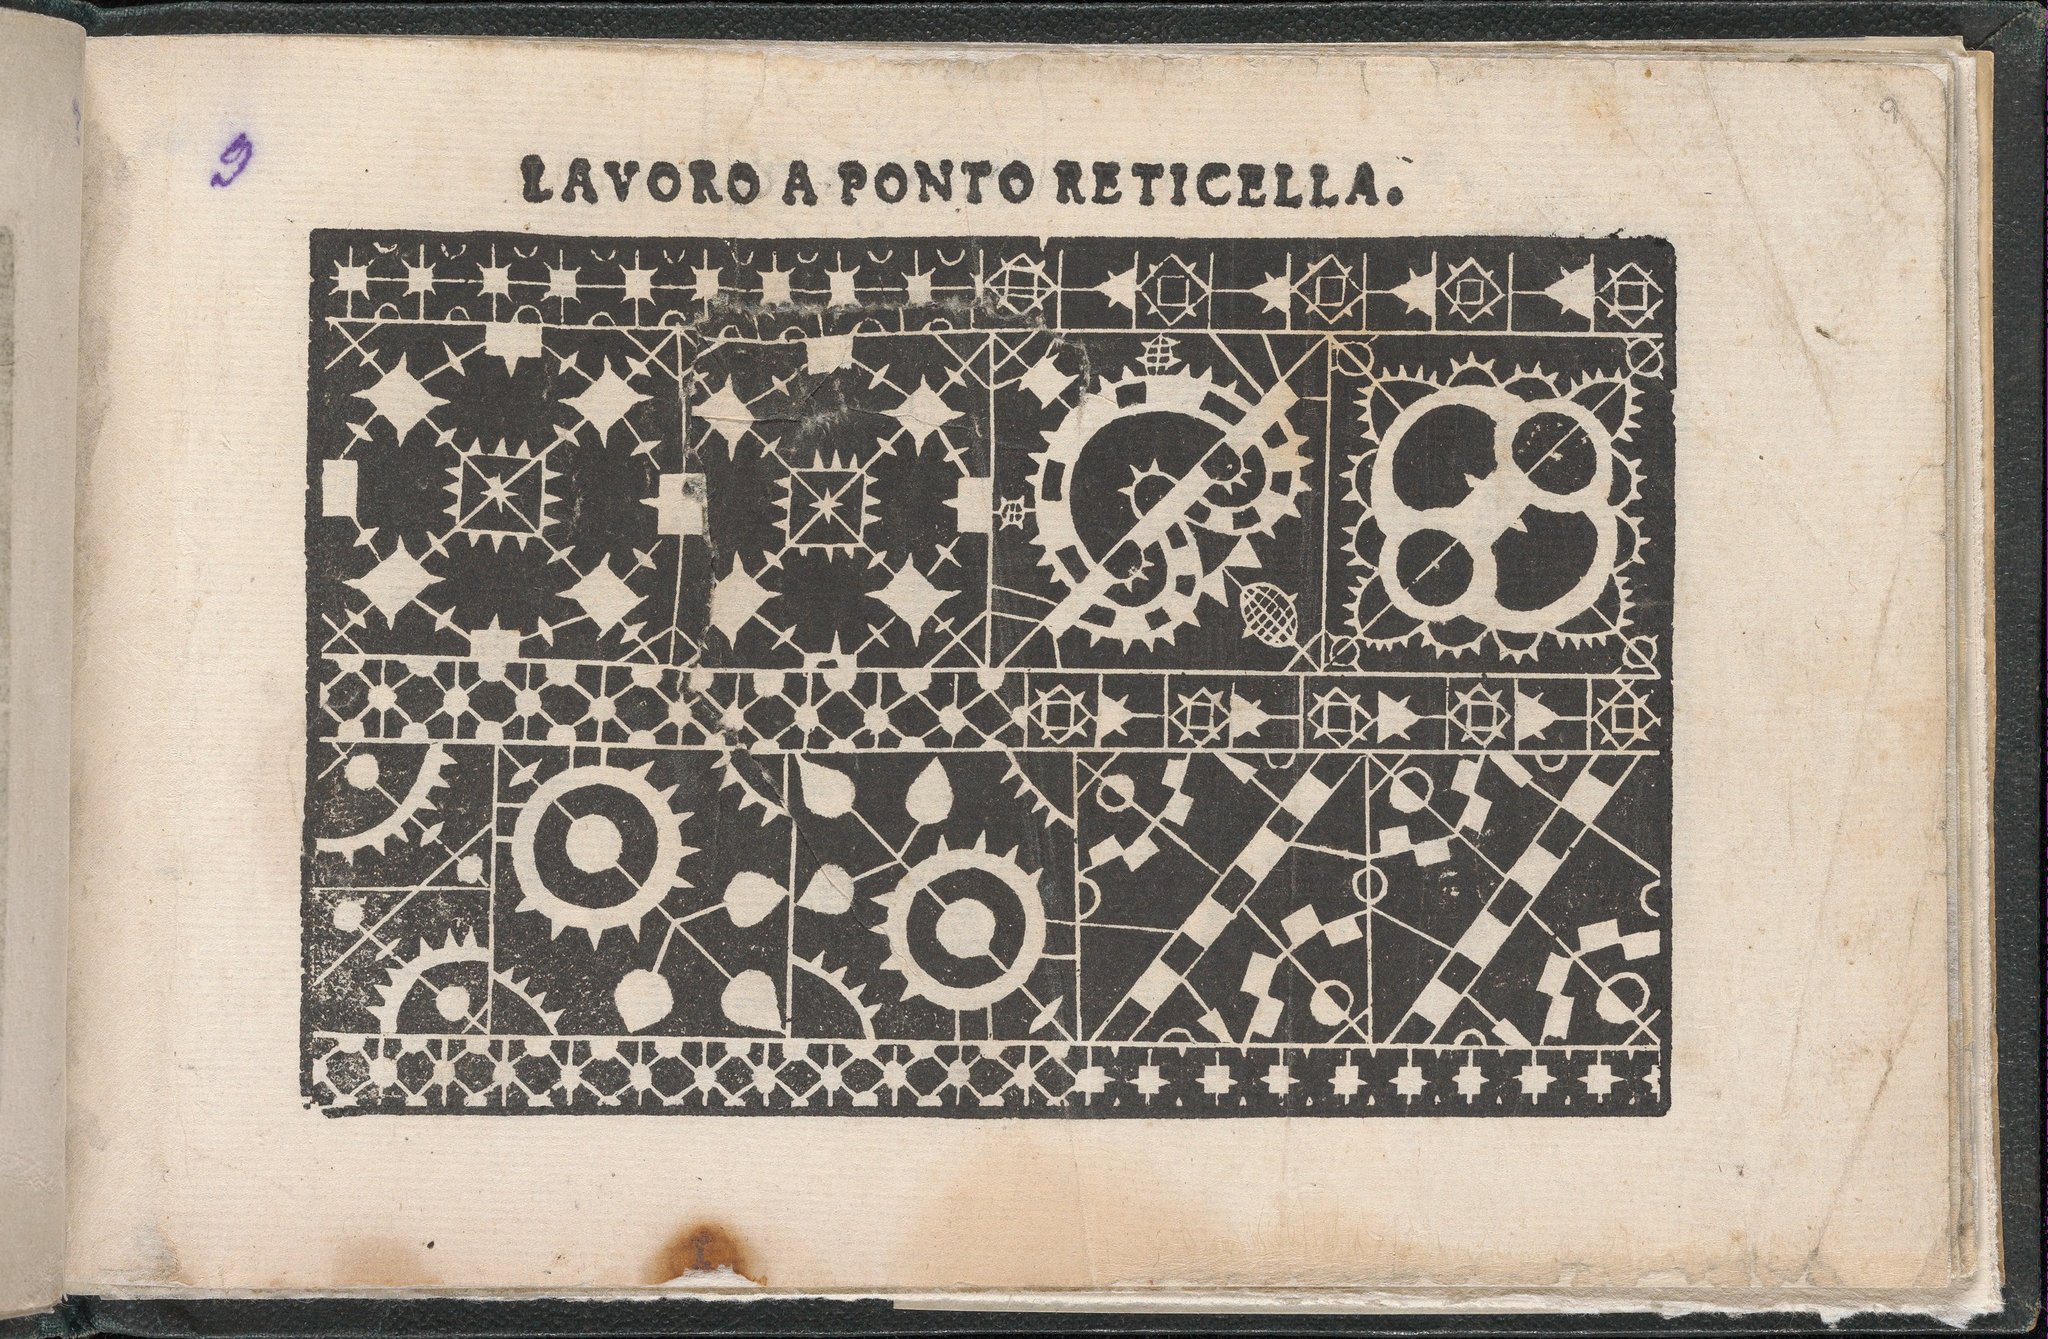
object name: book print ornament architecture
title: Gemma pretiosa della virtuose donne, page 9 (recto)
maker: isabella catanea parasole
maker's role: designer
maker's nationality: italian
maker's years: 1565-1625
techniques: woodcut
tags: ornament